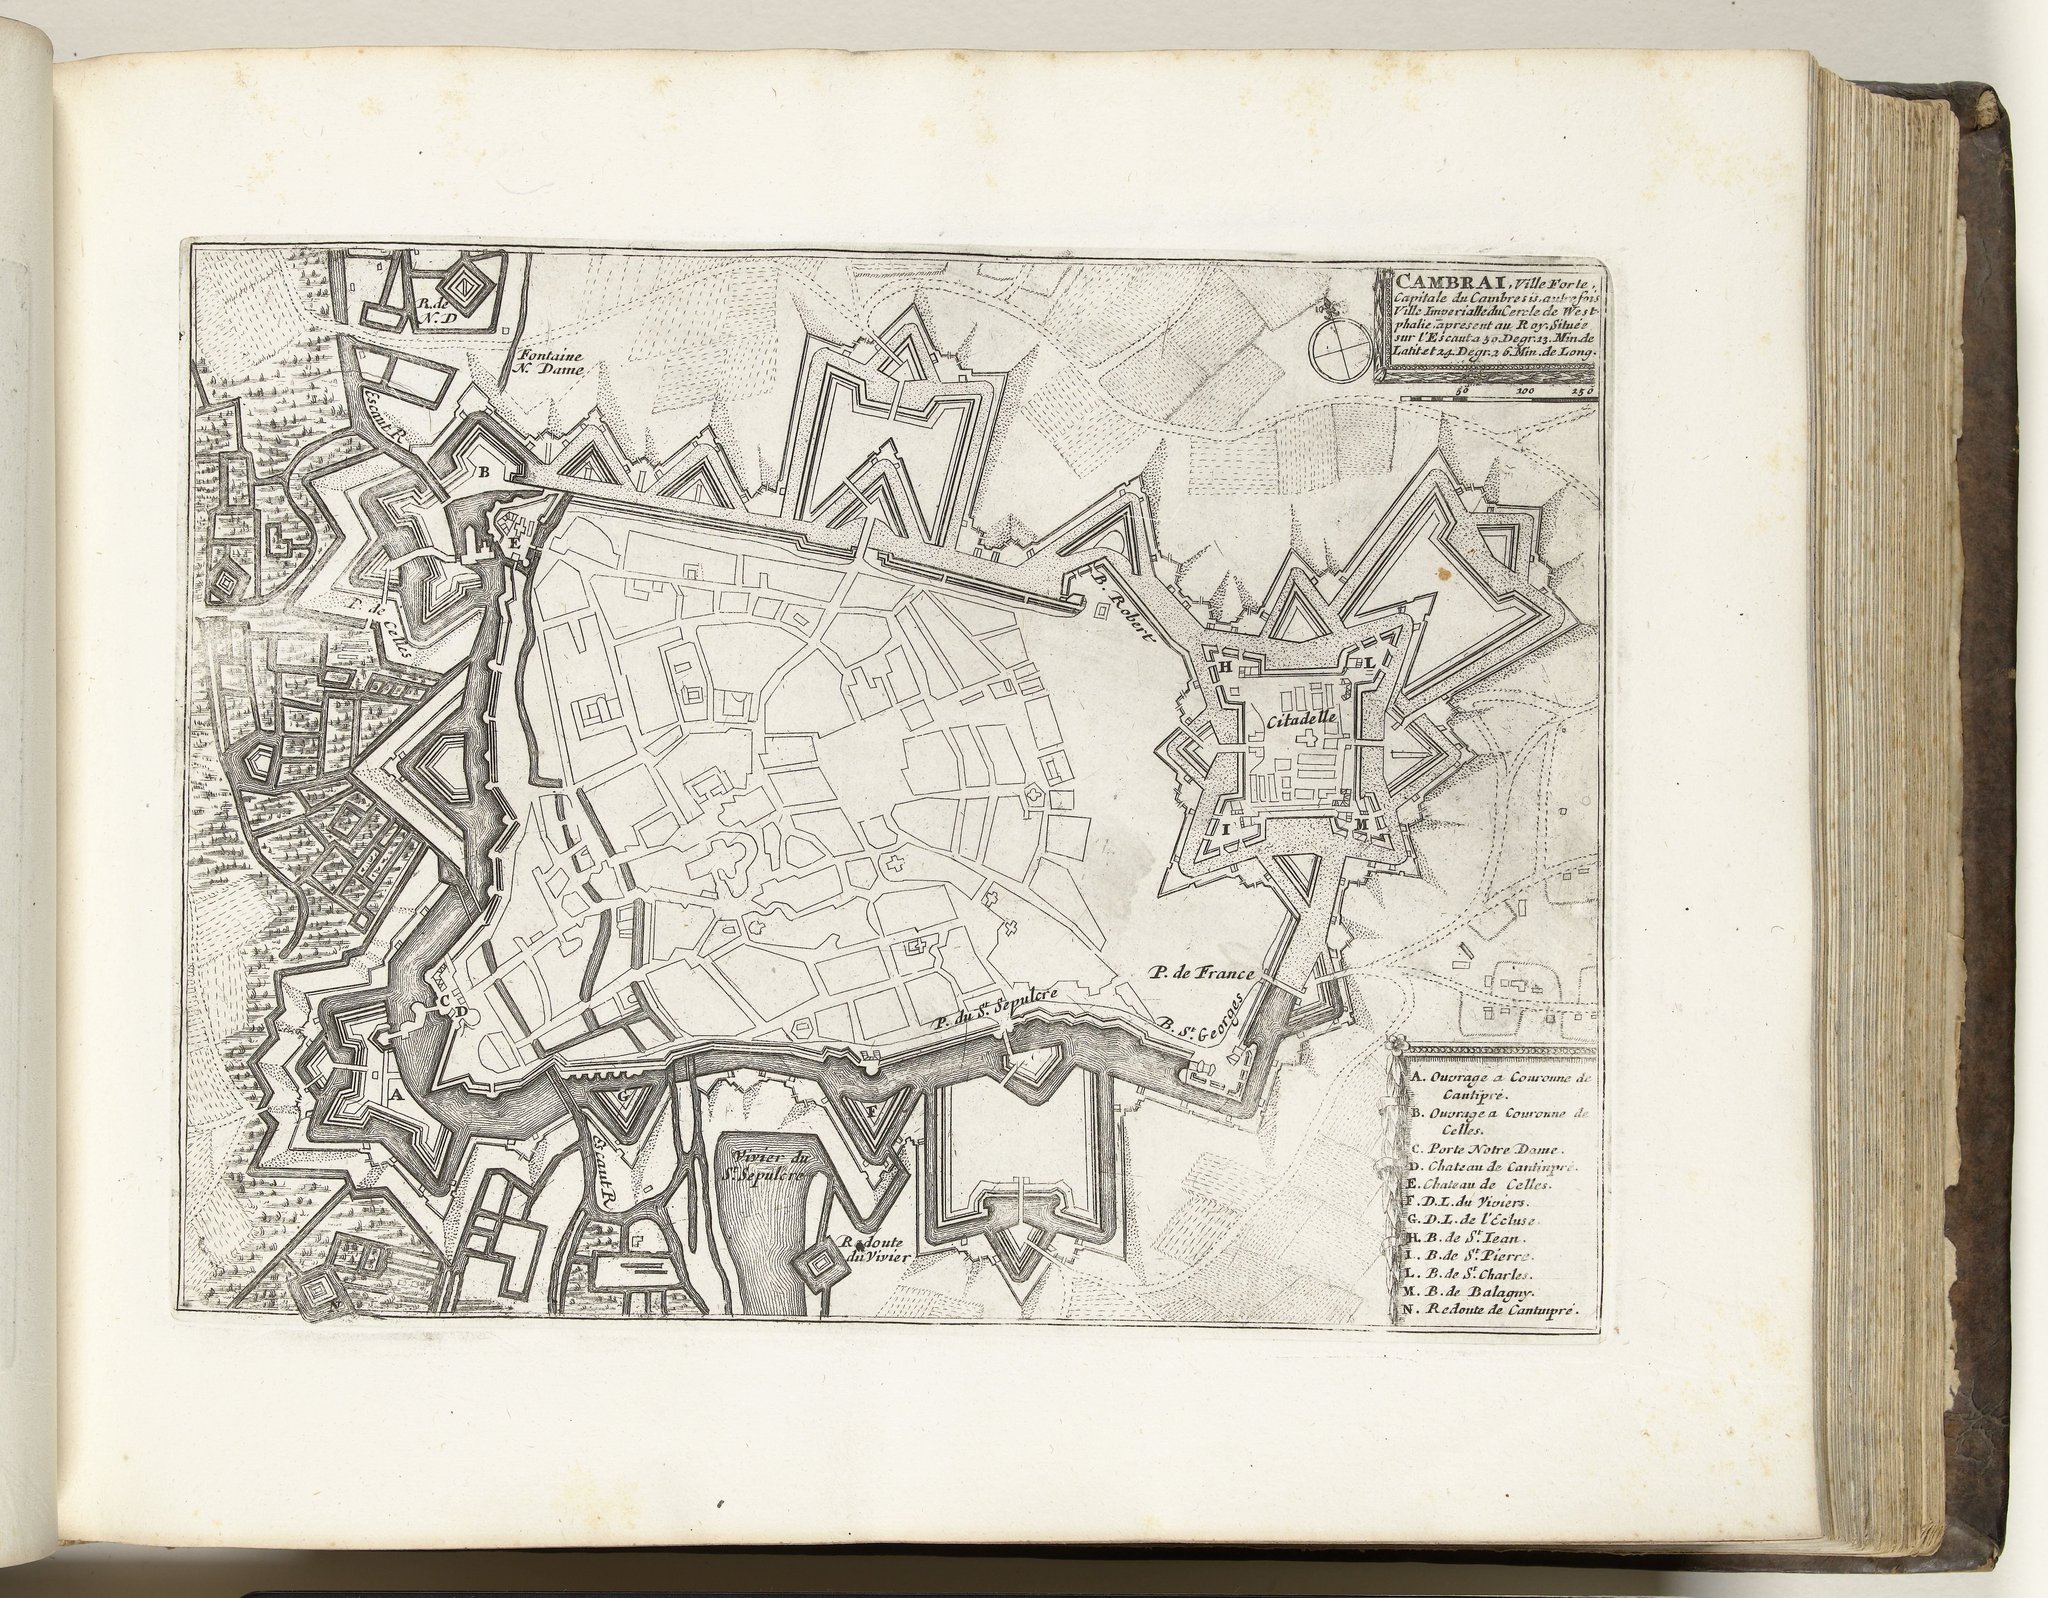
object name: print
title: Les forces de l'Europe, ou description des principales villes, avec leurs fortifications : dessignées par les meilleurs ingenieurs, particulierement celles (...) de la France, dont les plans ont esté levez par M. de Vauban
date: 1695-1697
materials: paper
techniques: etching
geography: france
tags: fortress, maps of cities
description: Plattegrond van de versterkingen om de Vlaamse stad Cambrai (Kamerijk). Onderdeel van het vierde deel (1697) van het prentwerk waarin gebundeld zijn de acht delen van Les forces de l'Europe uitgegeven tussen 1693-1697. Het prentwerk bestaat uit 175 platen met plannen (afkomstig van Sébastien Le Prestre, Seigneur de Vauban) van vermaarde sterke steden en vestingen in de Negenjarige Oorlog. Titel en opschriften in het Frans.